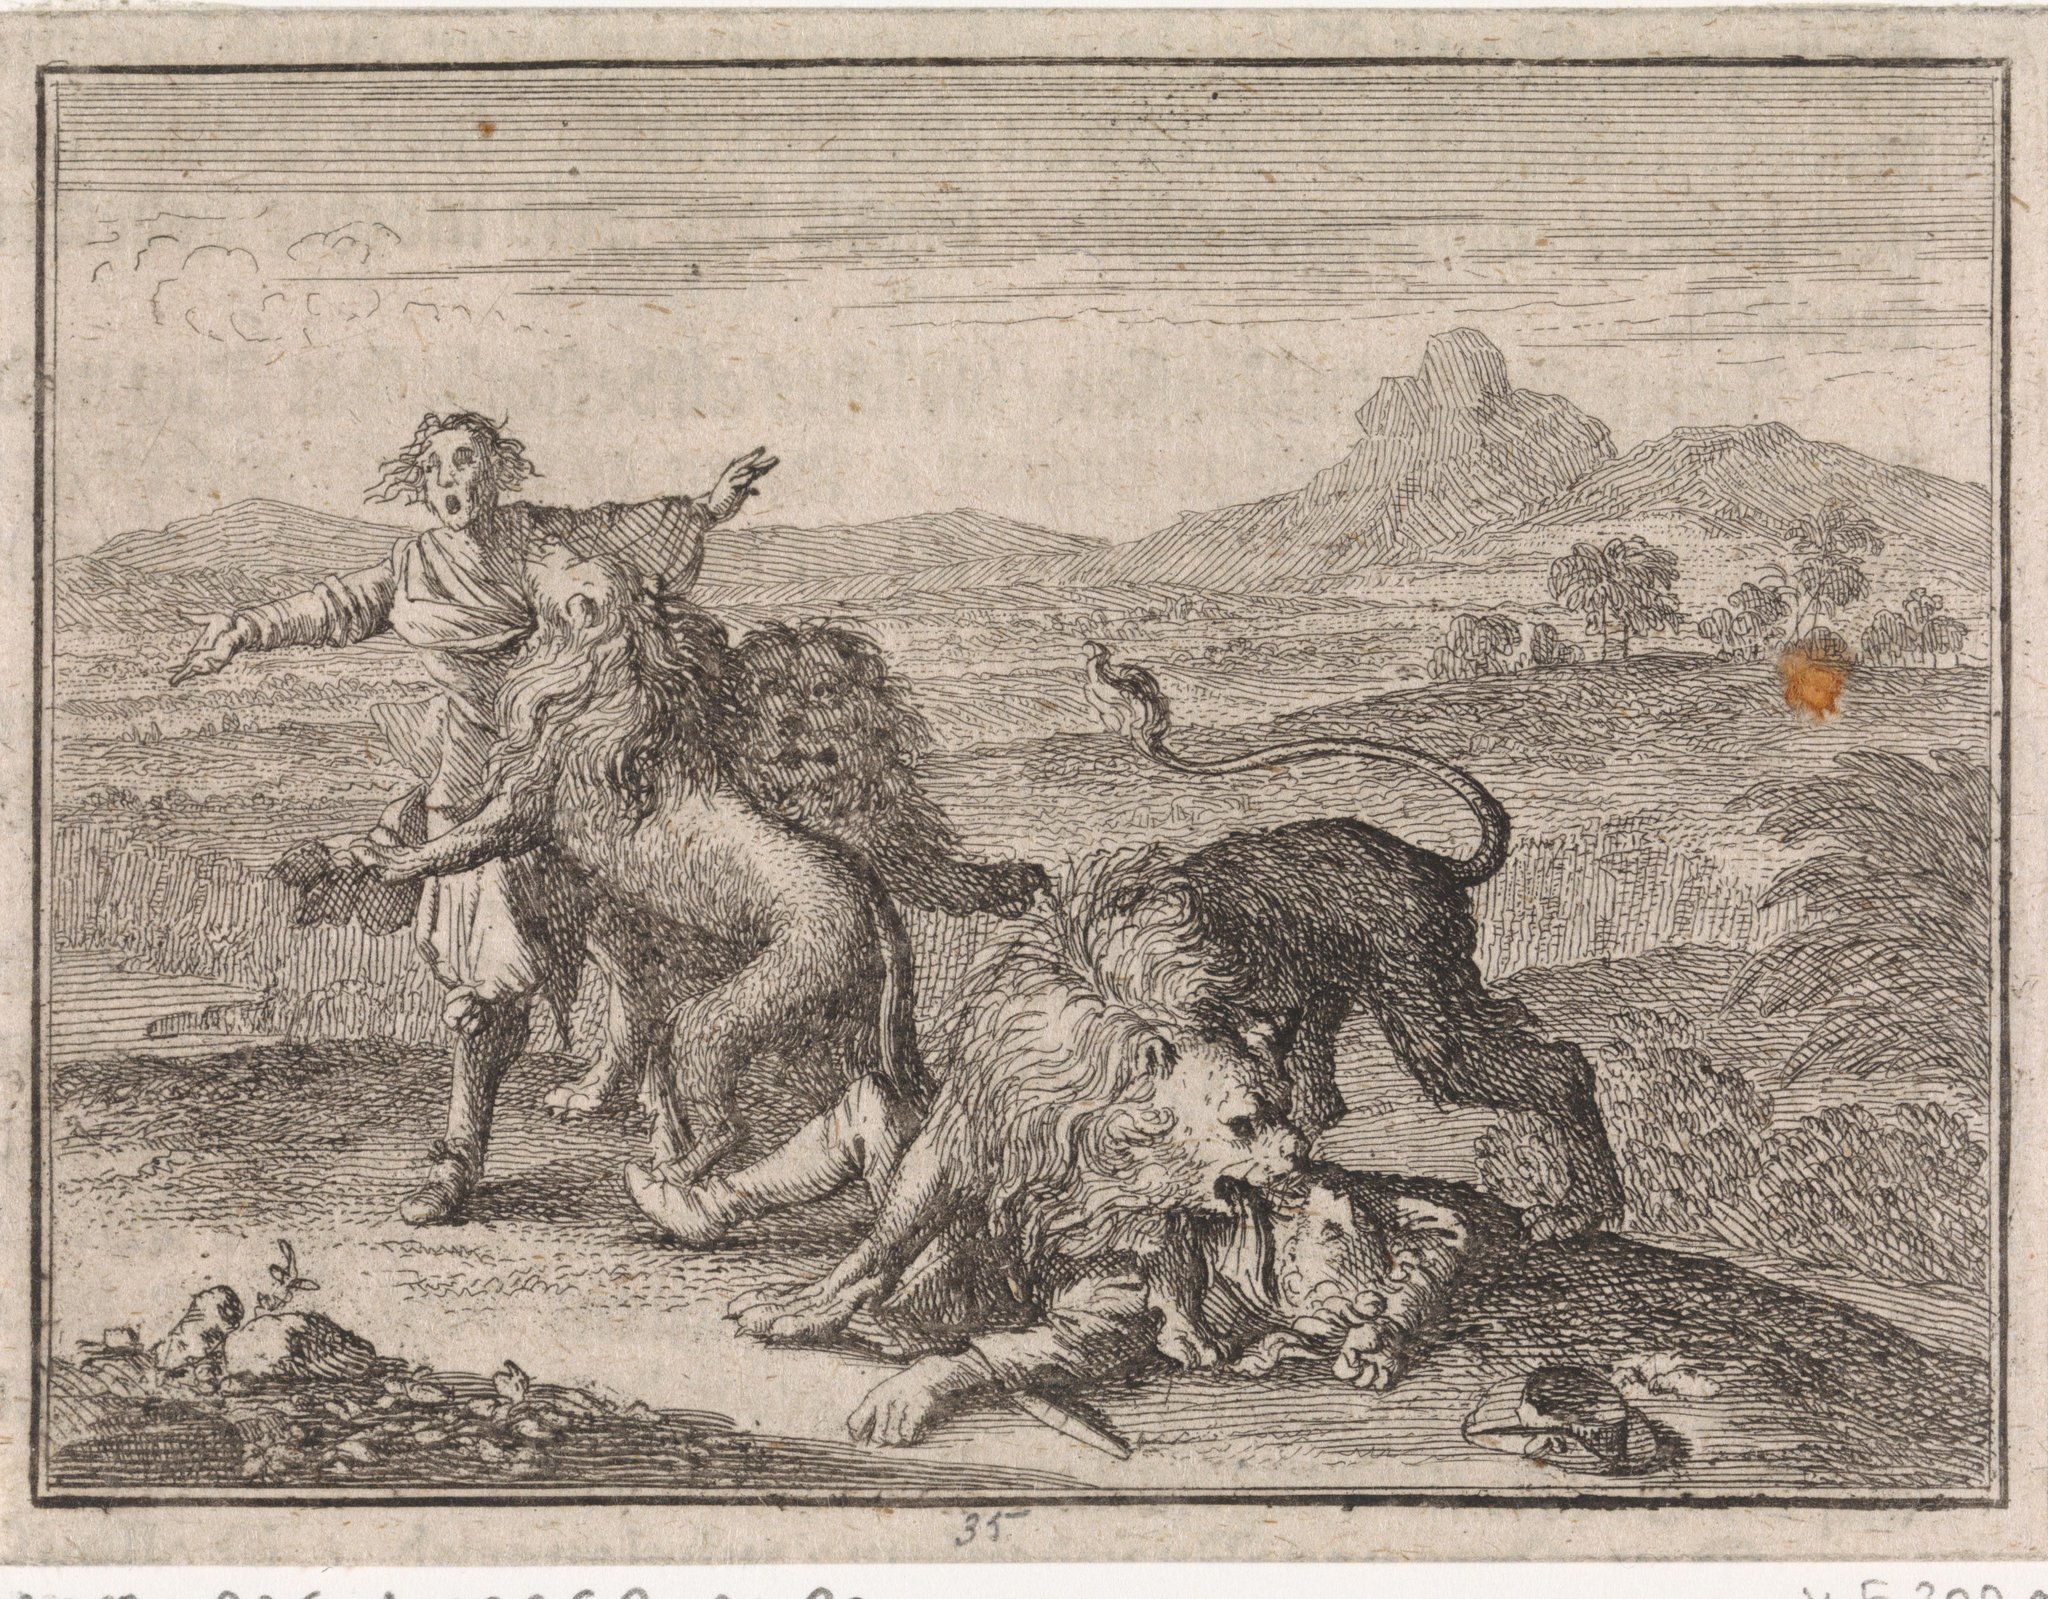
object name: book illustration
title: Twee Abyssinische edelen worden door leeuwen verscheurd op de akker die zij tijdens hun jacht ruïneerde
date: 1710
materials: paper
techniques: etching, letterpress printing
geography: nuremberg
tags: beasts of prey, predatory animals: lion (+ man and animal), landscapes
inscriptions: collector's mark: Lugt 2228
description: Illustratie uit: Abraham a Sancta Clara. Heilsames Gemisch Gemasch, das ist: Allerley seltsame und verwunderliche Geschichten (...). Neurenberg: Christoph Weigel, 1710, p. 341.